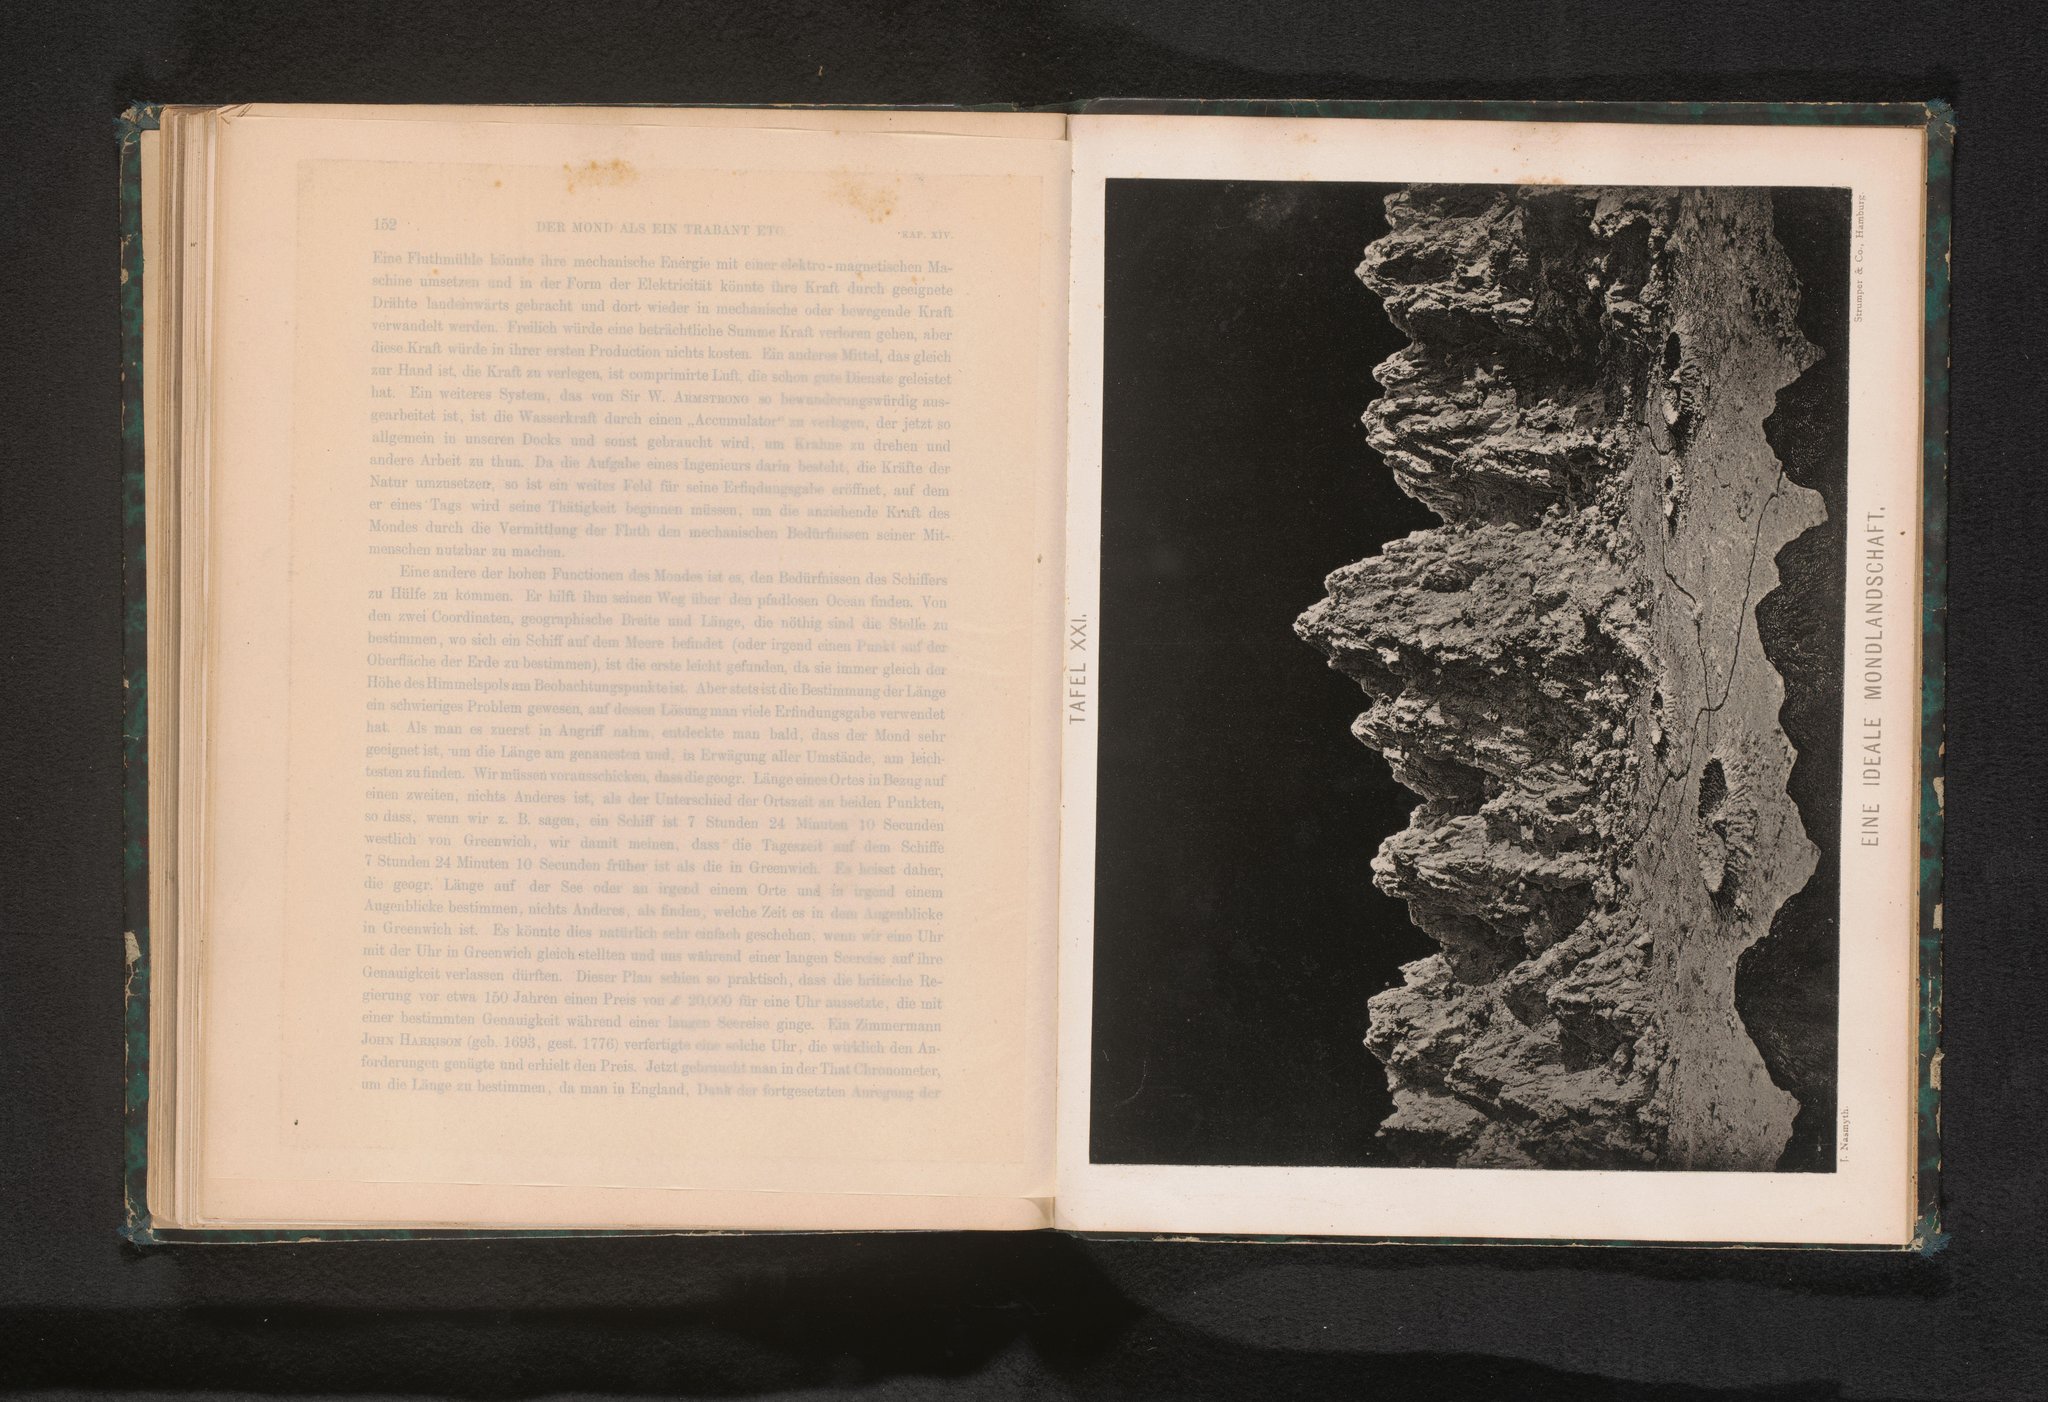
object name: photomechanical print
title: Gezicht op een bergketen op de maan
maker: james nasmyth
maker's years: 1808-1890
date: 1863-1873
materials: paper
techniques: photograph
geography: hamburg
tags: surface of the moon, moon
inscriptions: number: ‘Tafel XXI.’